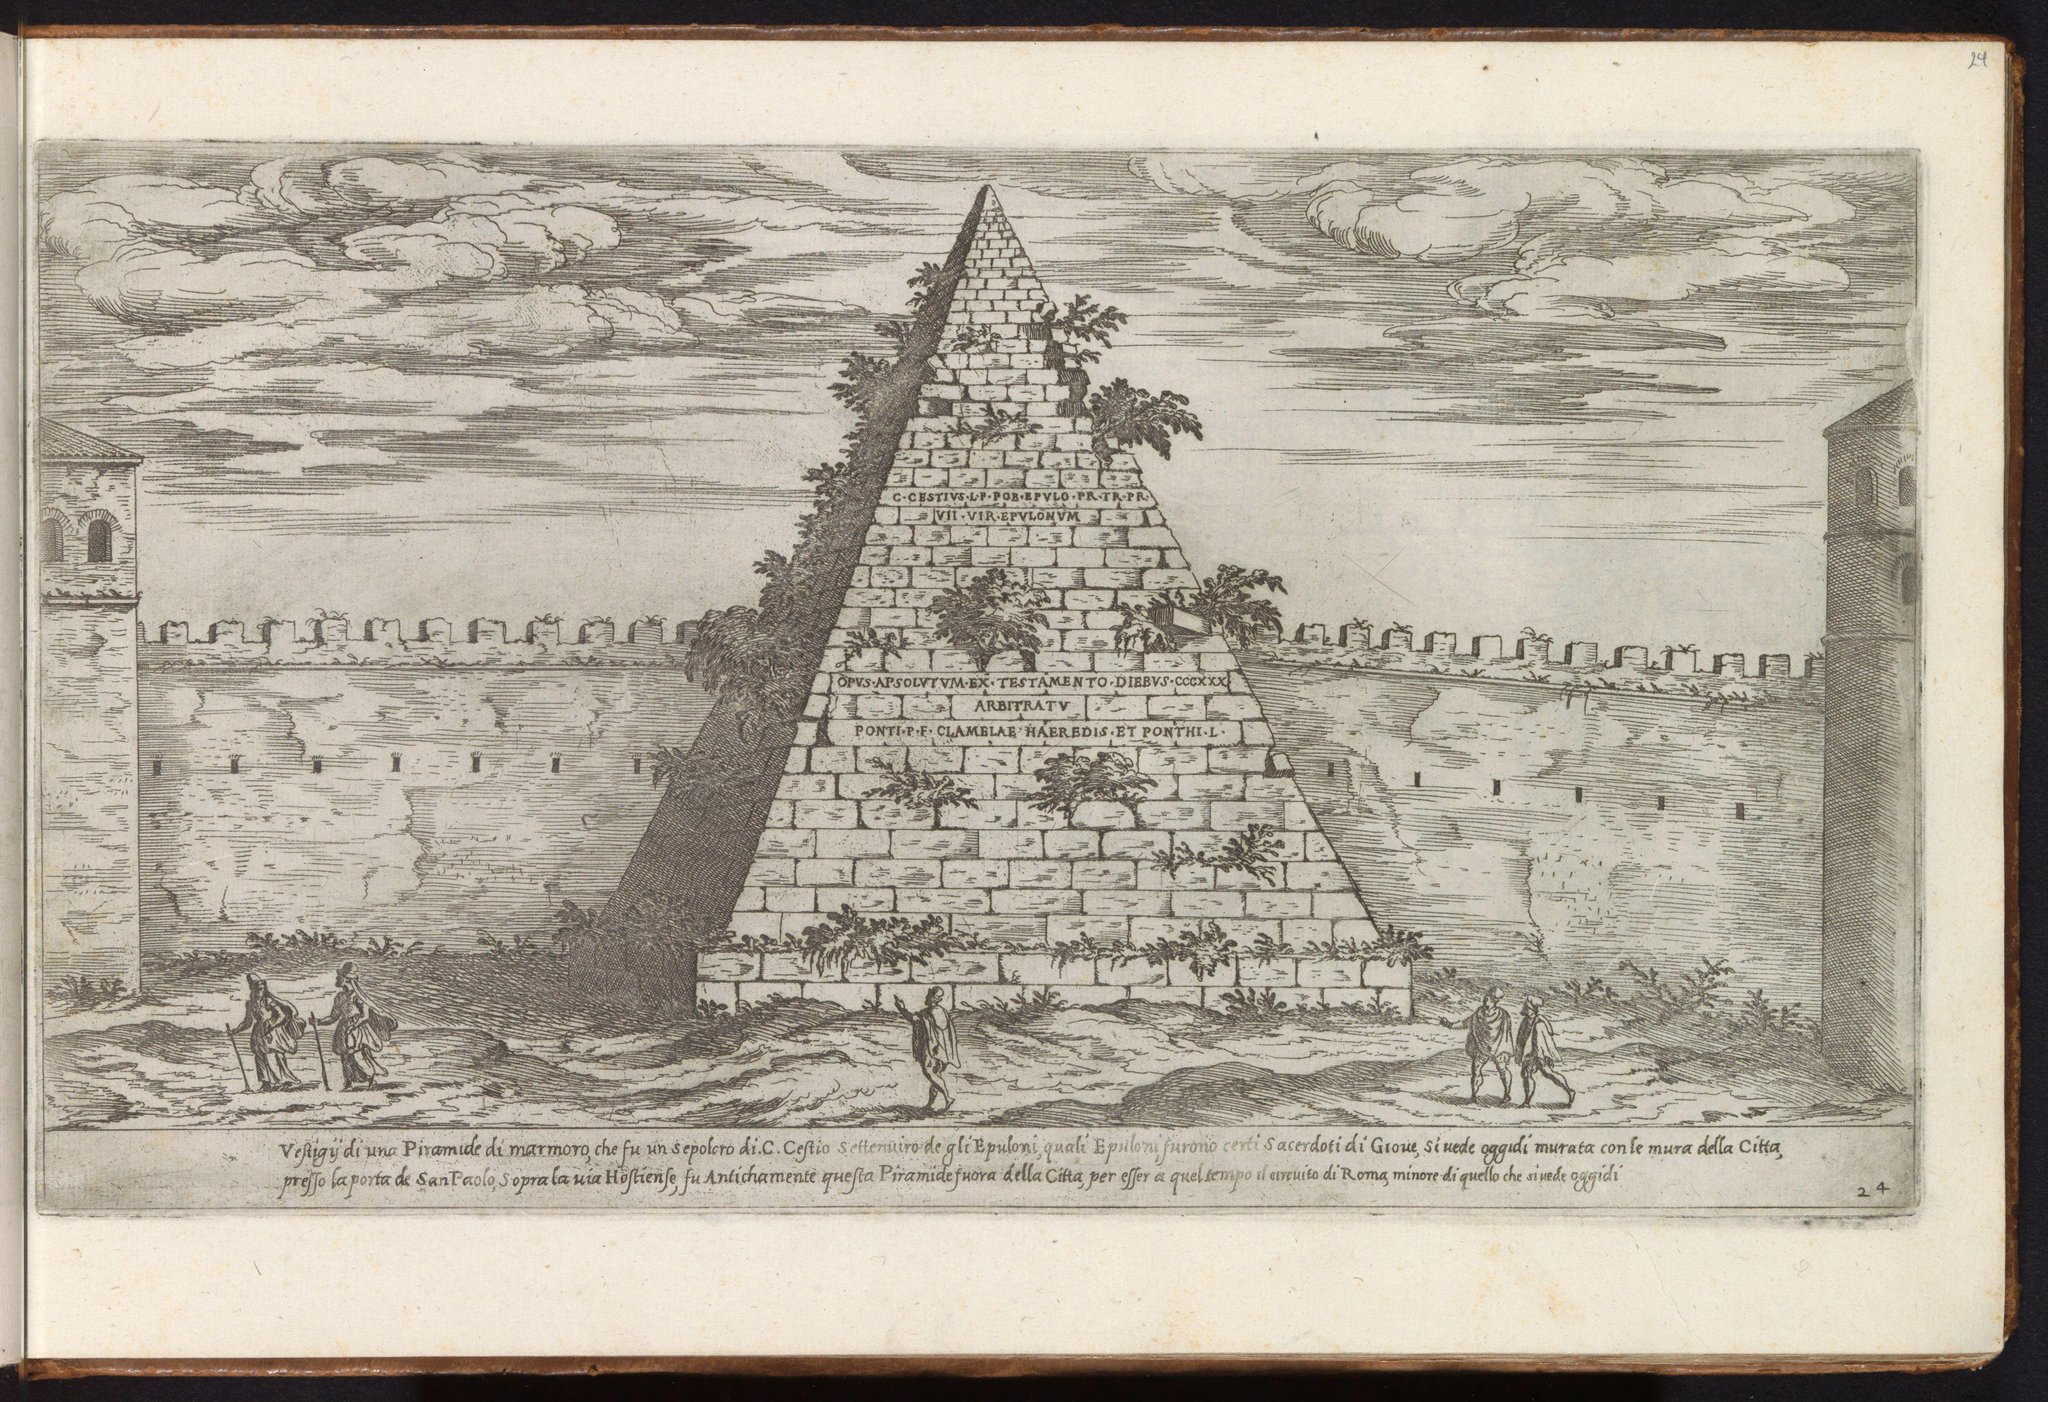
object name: album leaf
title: I vestigi dell'antichità di Roma raccolti et ritratti in perspettiva da Stefano Du Perac Parisino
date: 1575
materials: paper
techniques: engraving, etching, intaglio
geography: rome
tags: city-view, and landscape with man-made constructions, ruin of a building ~ architecture, landscape with ruins, pyramid (marking grave)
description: Gezicht op de Piramide van Cestius te Rome. Onderschrift in het Italiaans. Prent maakt deel uit van een album.